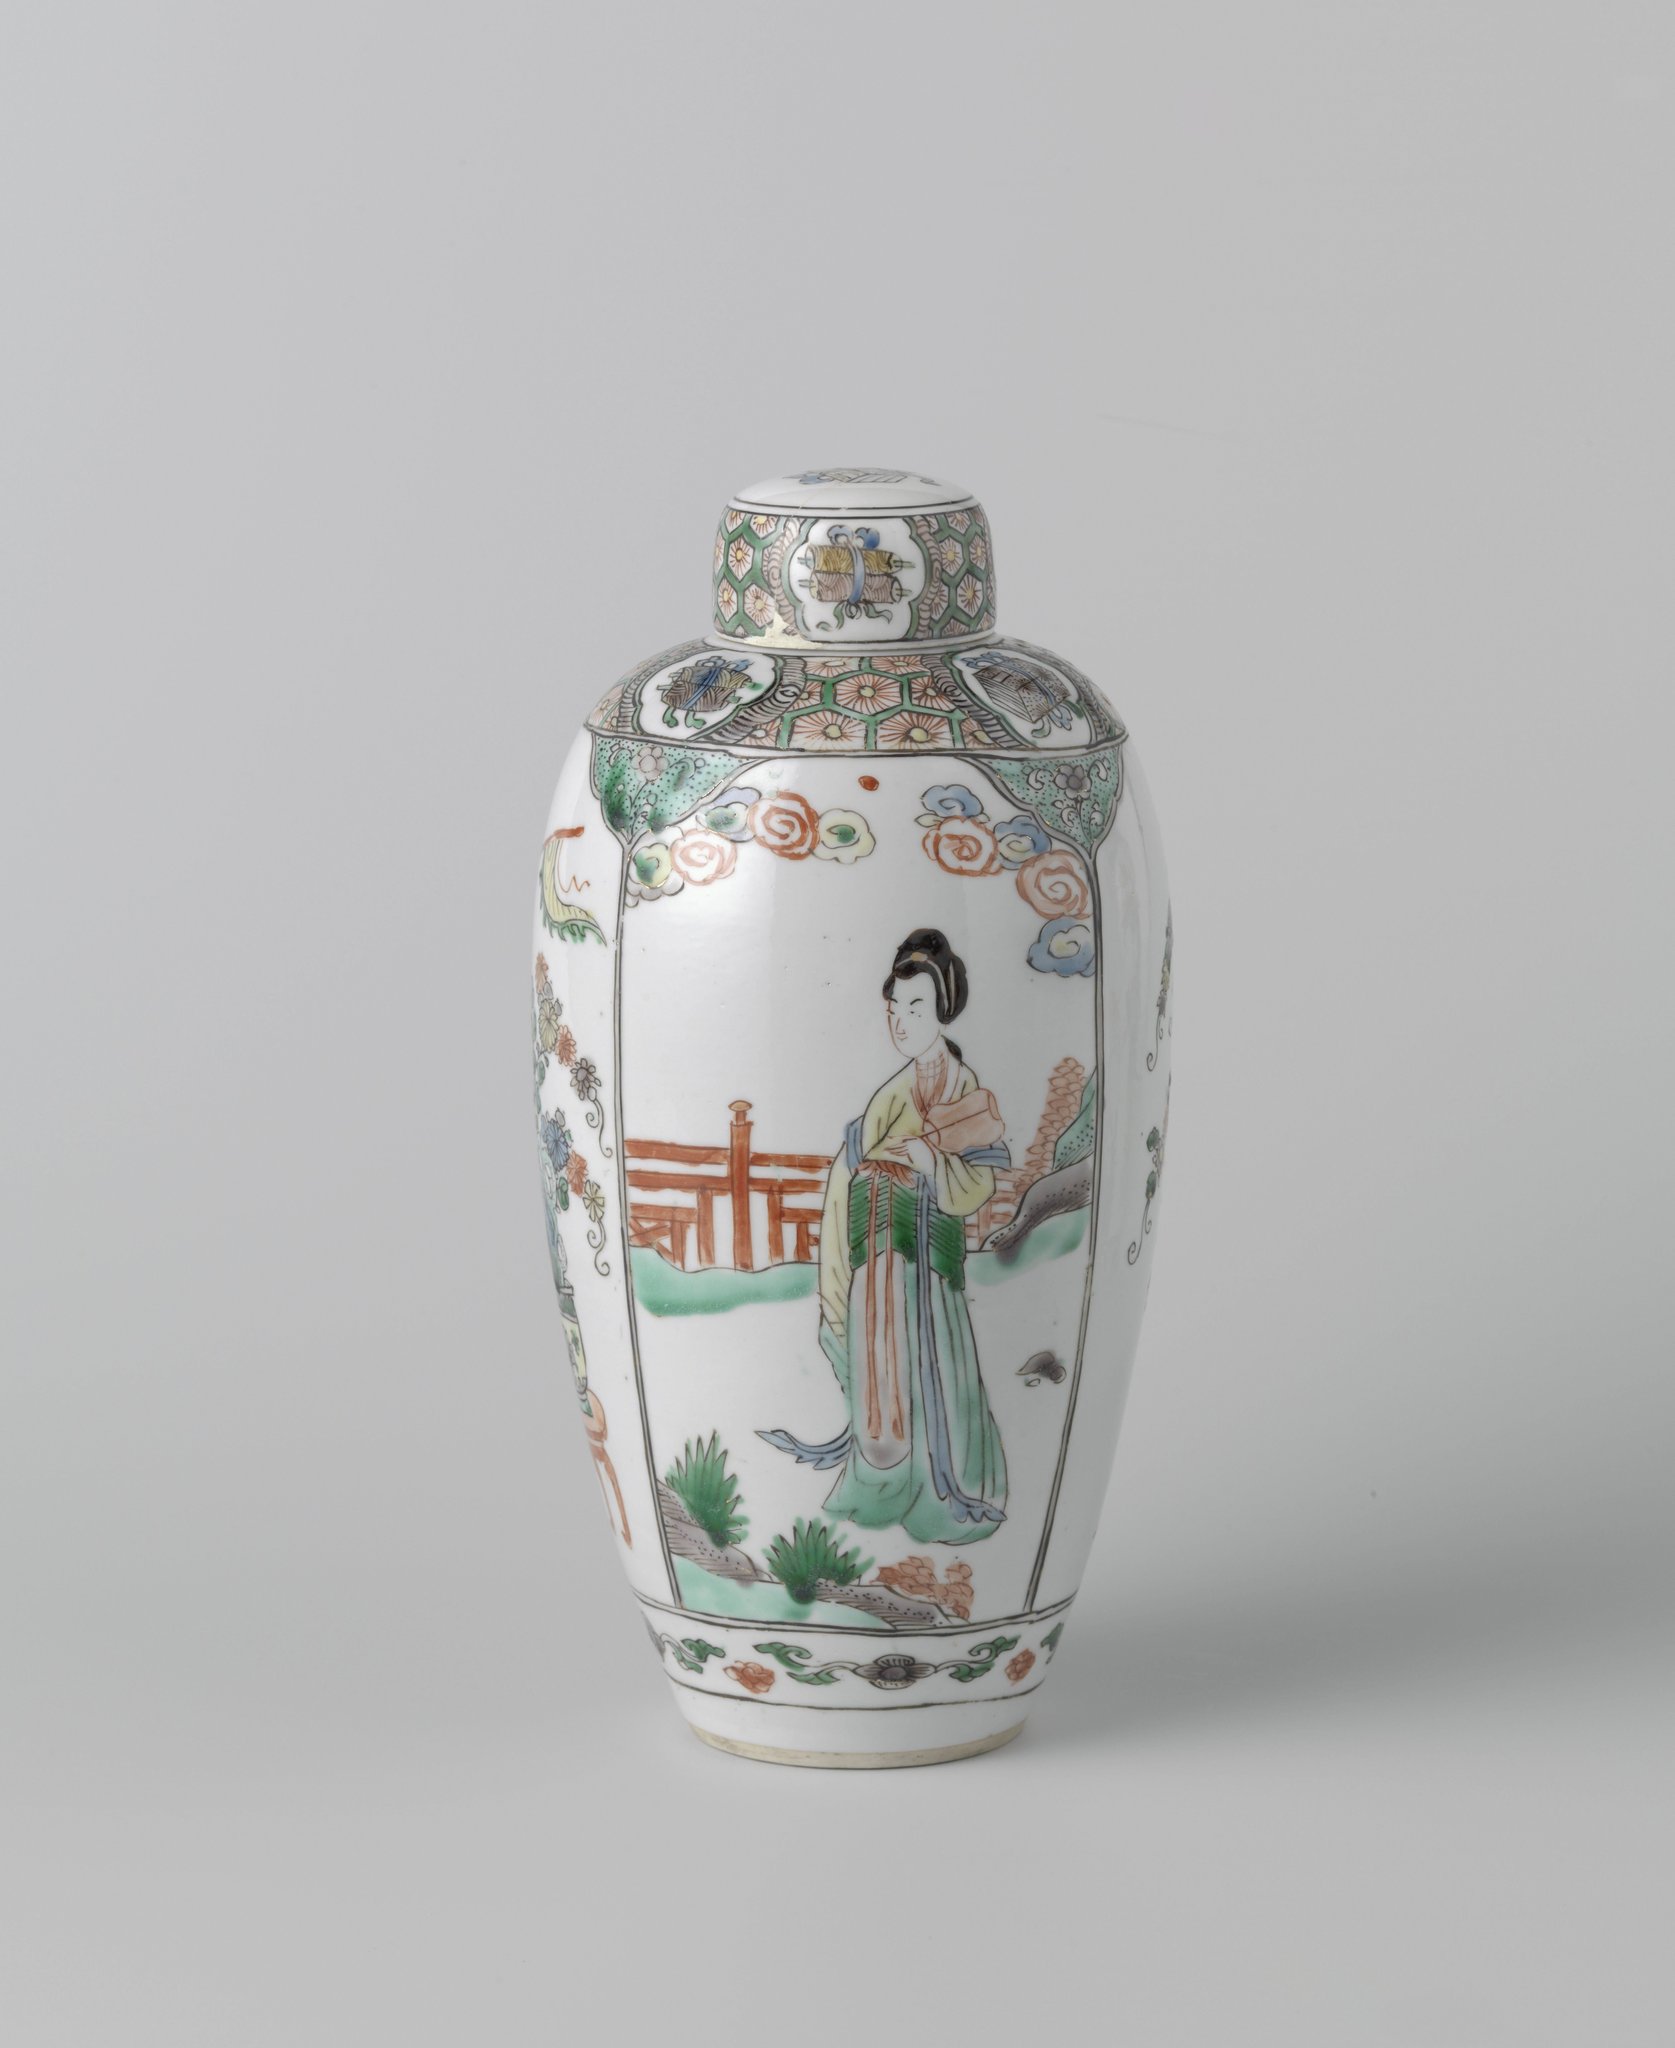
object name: covered jar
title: Ovoid covered jar with women and flower pots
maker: Anonymous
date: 1700-1724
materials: glaze, paint, porcelain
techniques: firing, turning, vitrification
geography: china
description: Eivormige dekselpot van porselein, beschilderd op het glazuur in blauw, rood, groen, geel, aubergine en zwart. De wand is verdeeld in vier vakken met daarin afwisselend een vrouw met een waaier in een omheinde tuin en een bloempot met bloeiende planten (chrysant), een rots en een vaandel. Boven de voet een band met bloemranken. De schouder met een band servetwerk onderbroken door antiquiteiten in cartouches (qin, rollen, boeken, go-spel). De deksel met antiquiteiten en servetwerk. Famille verte.